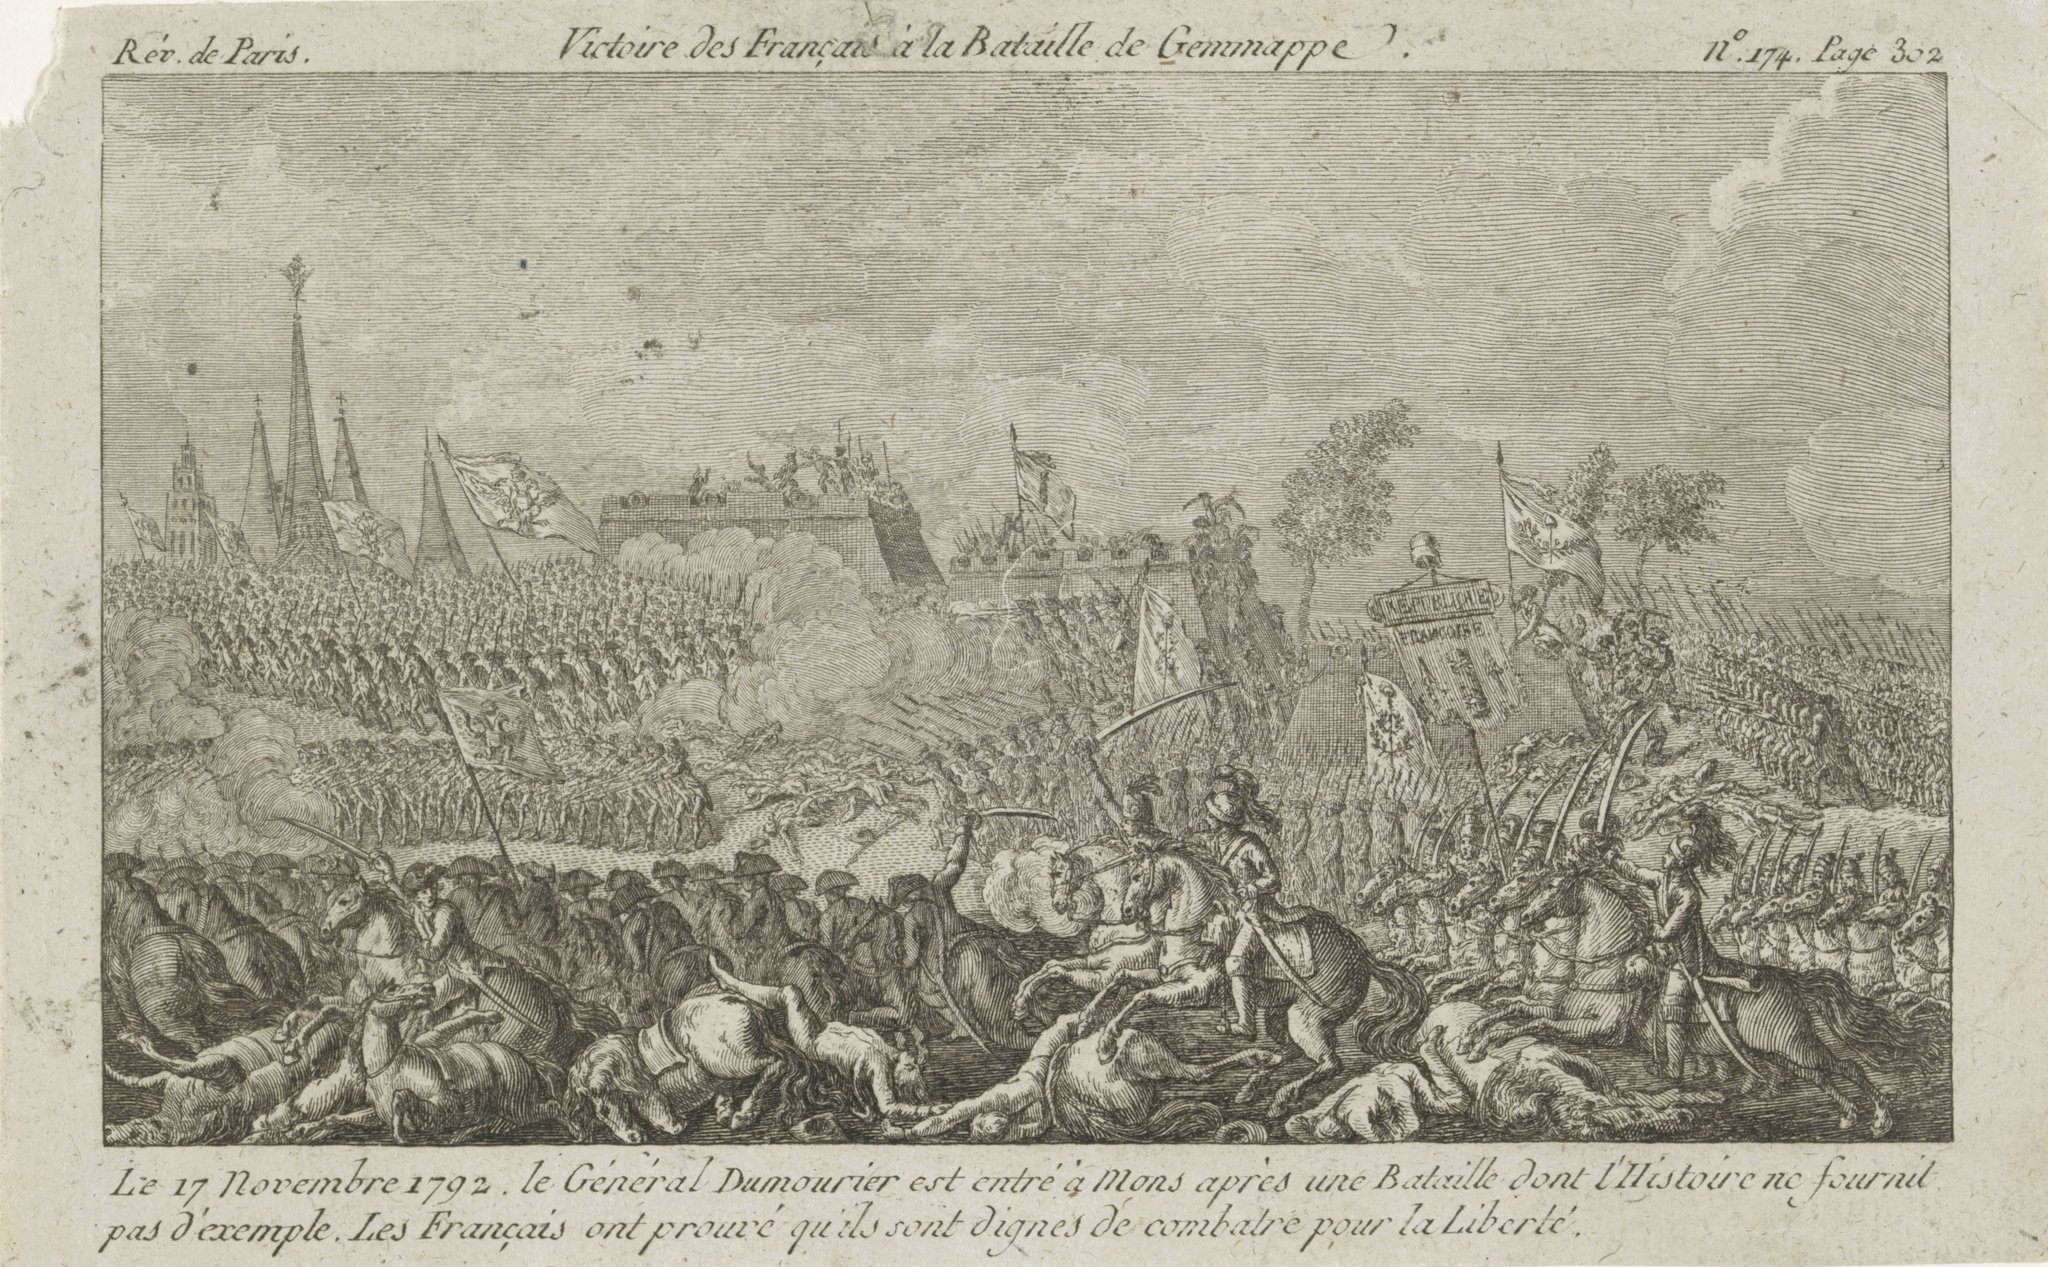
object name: print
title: Slag bij Jemappes, 1792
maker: Anonymous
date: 1792-1793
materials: paper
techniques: engraving, etching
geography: france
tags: battle (+ land forces)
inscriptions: collector's mark: Lugt 2228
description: Slag bij Jemappes in Henegouwen met een overwinning van de Franse revolutionaire troepen onder generaal Charles-François Dumouriez op het Oostenrijkse leger, 6 november 1792. Met tweereglig Frans onderschrift.